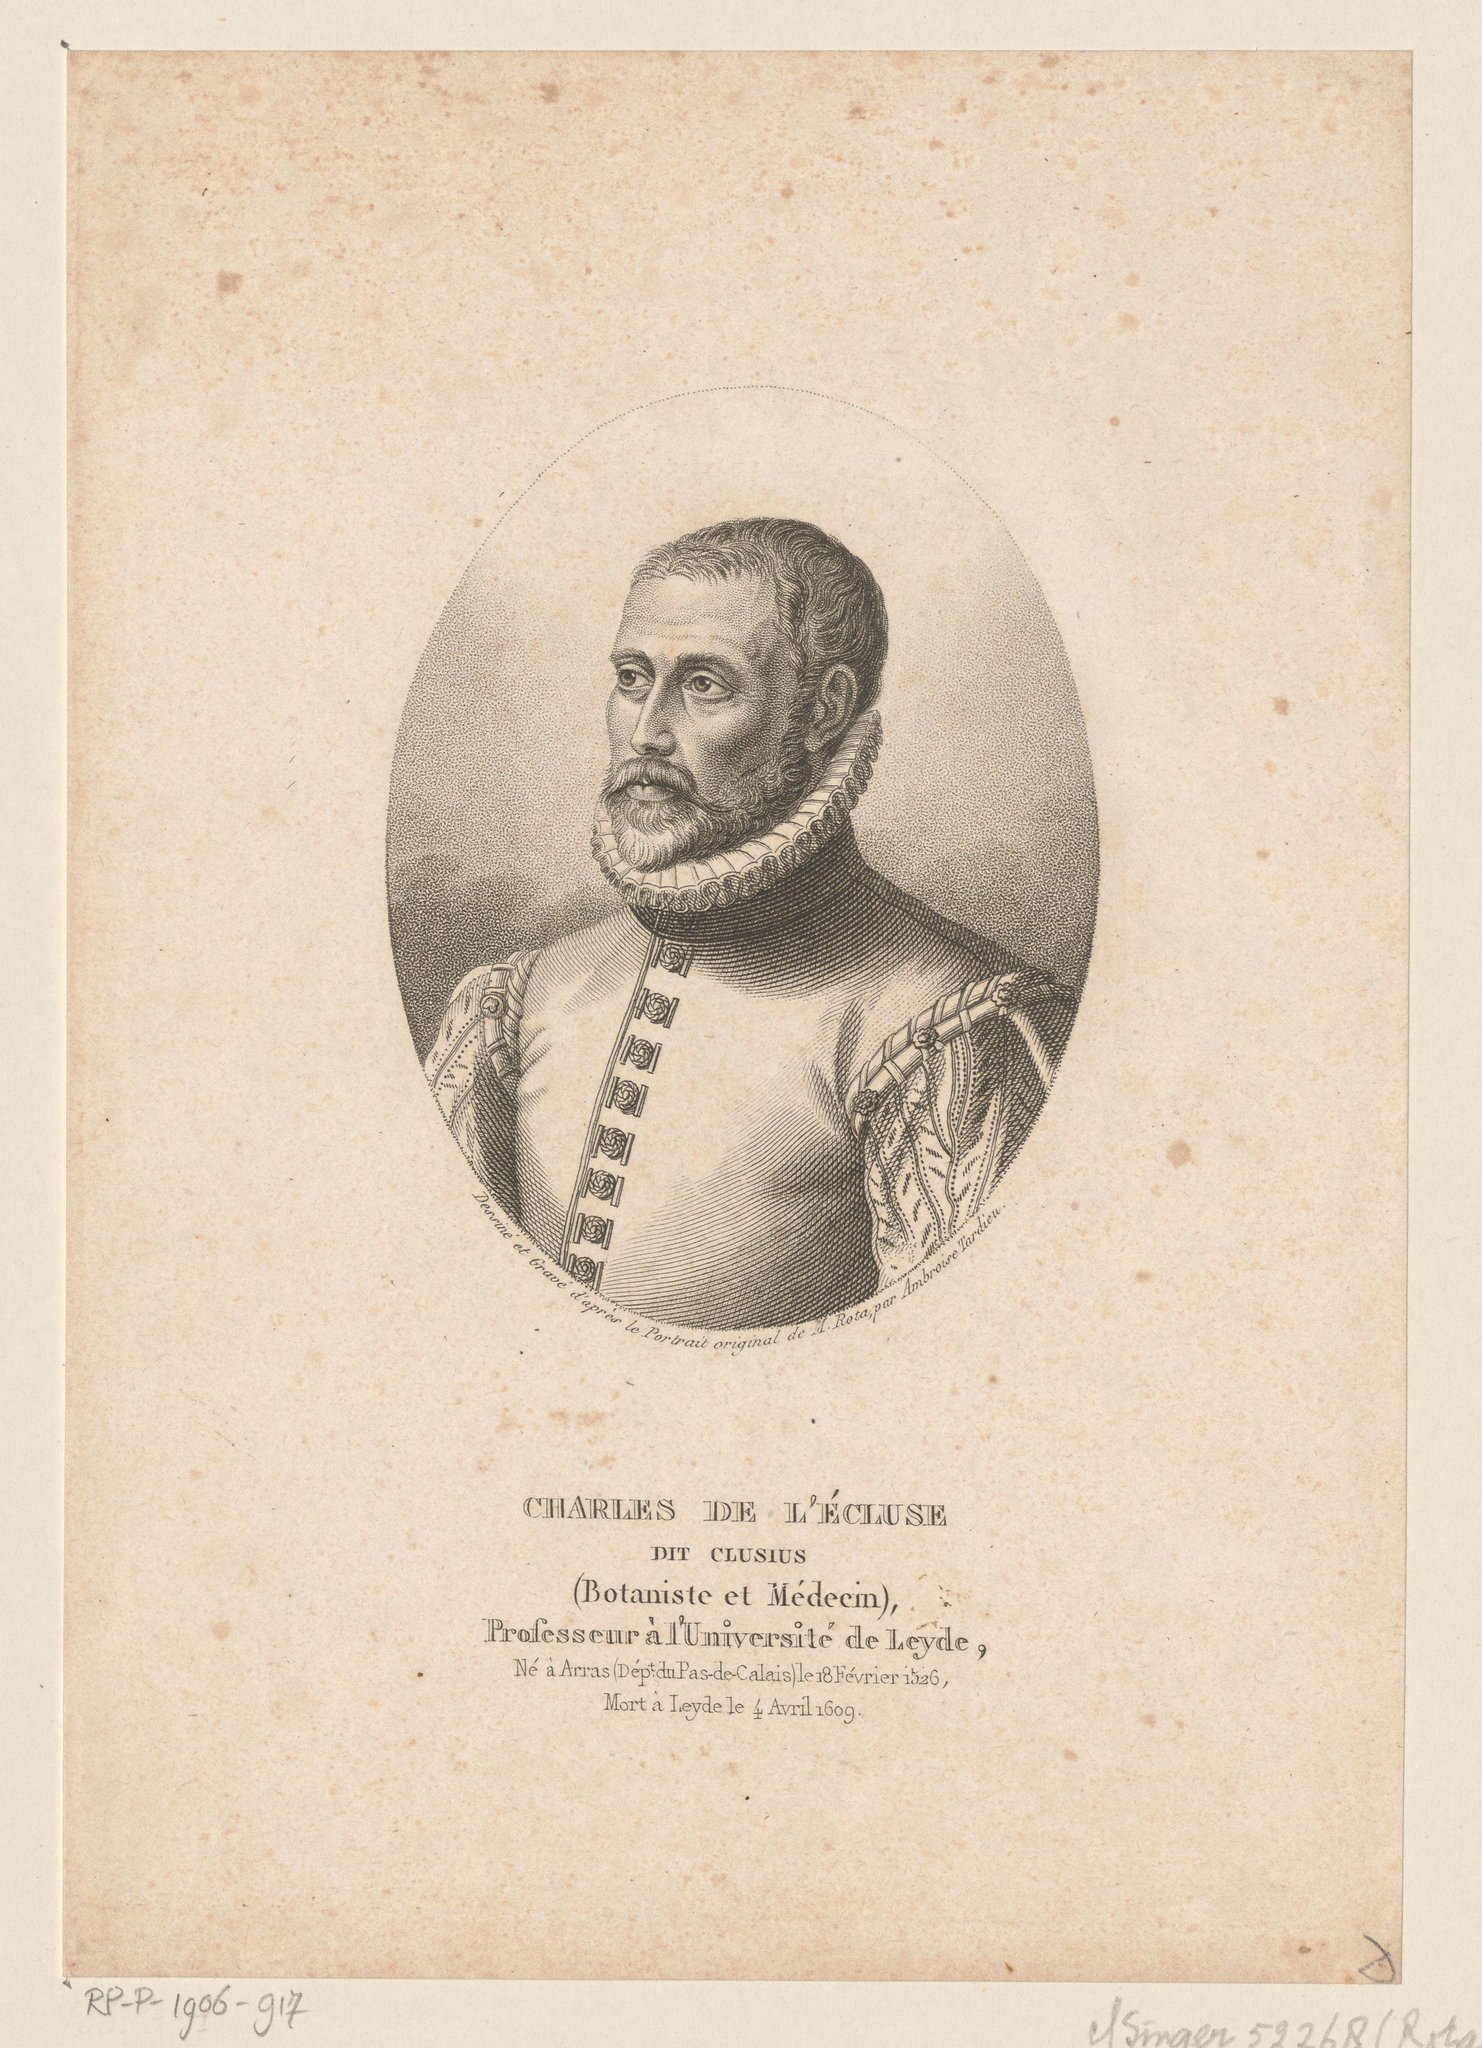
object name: print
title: Collectie van beroemde portretten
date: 1798-1841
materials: paper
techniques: engraving, etching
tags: leiden, historical persons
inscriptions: collector's mark: Lugt 2228